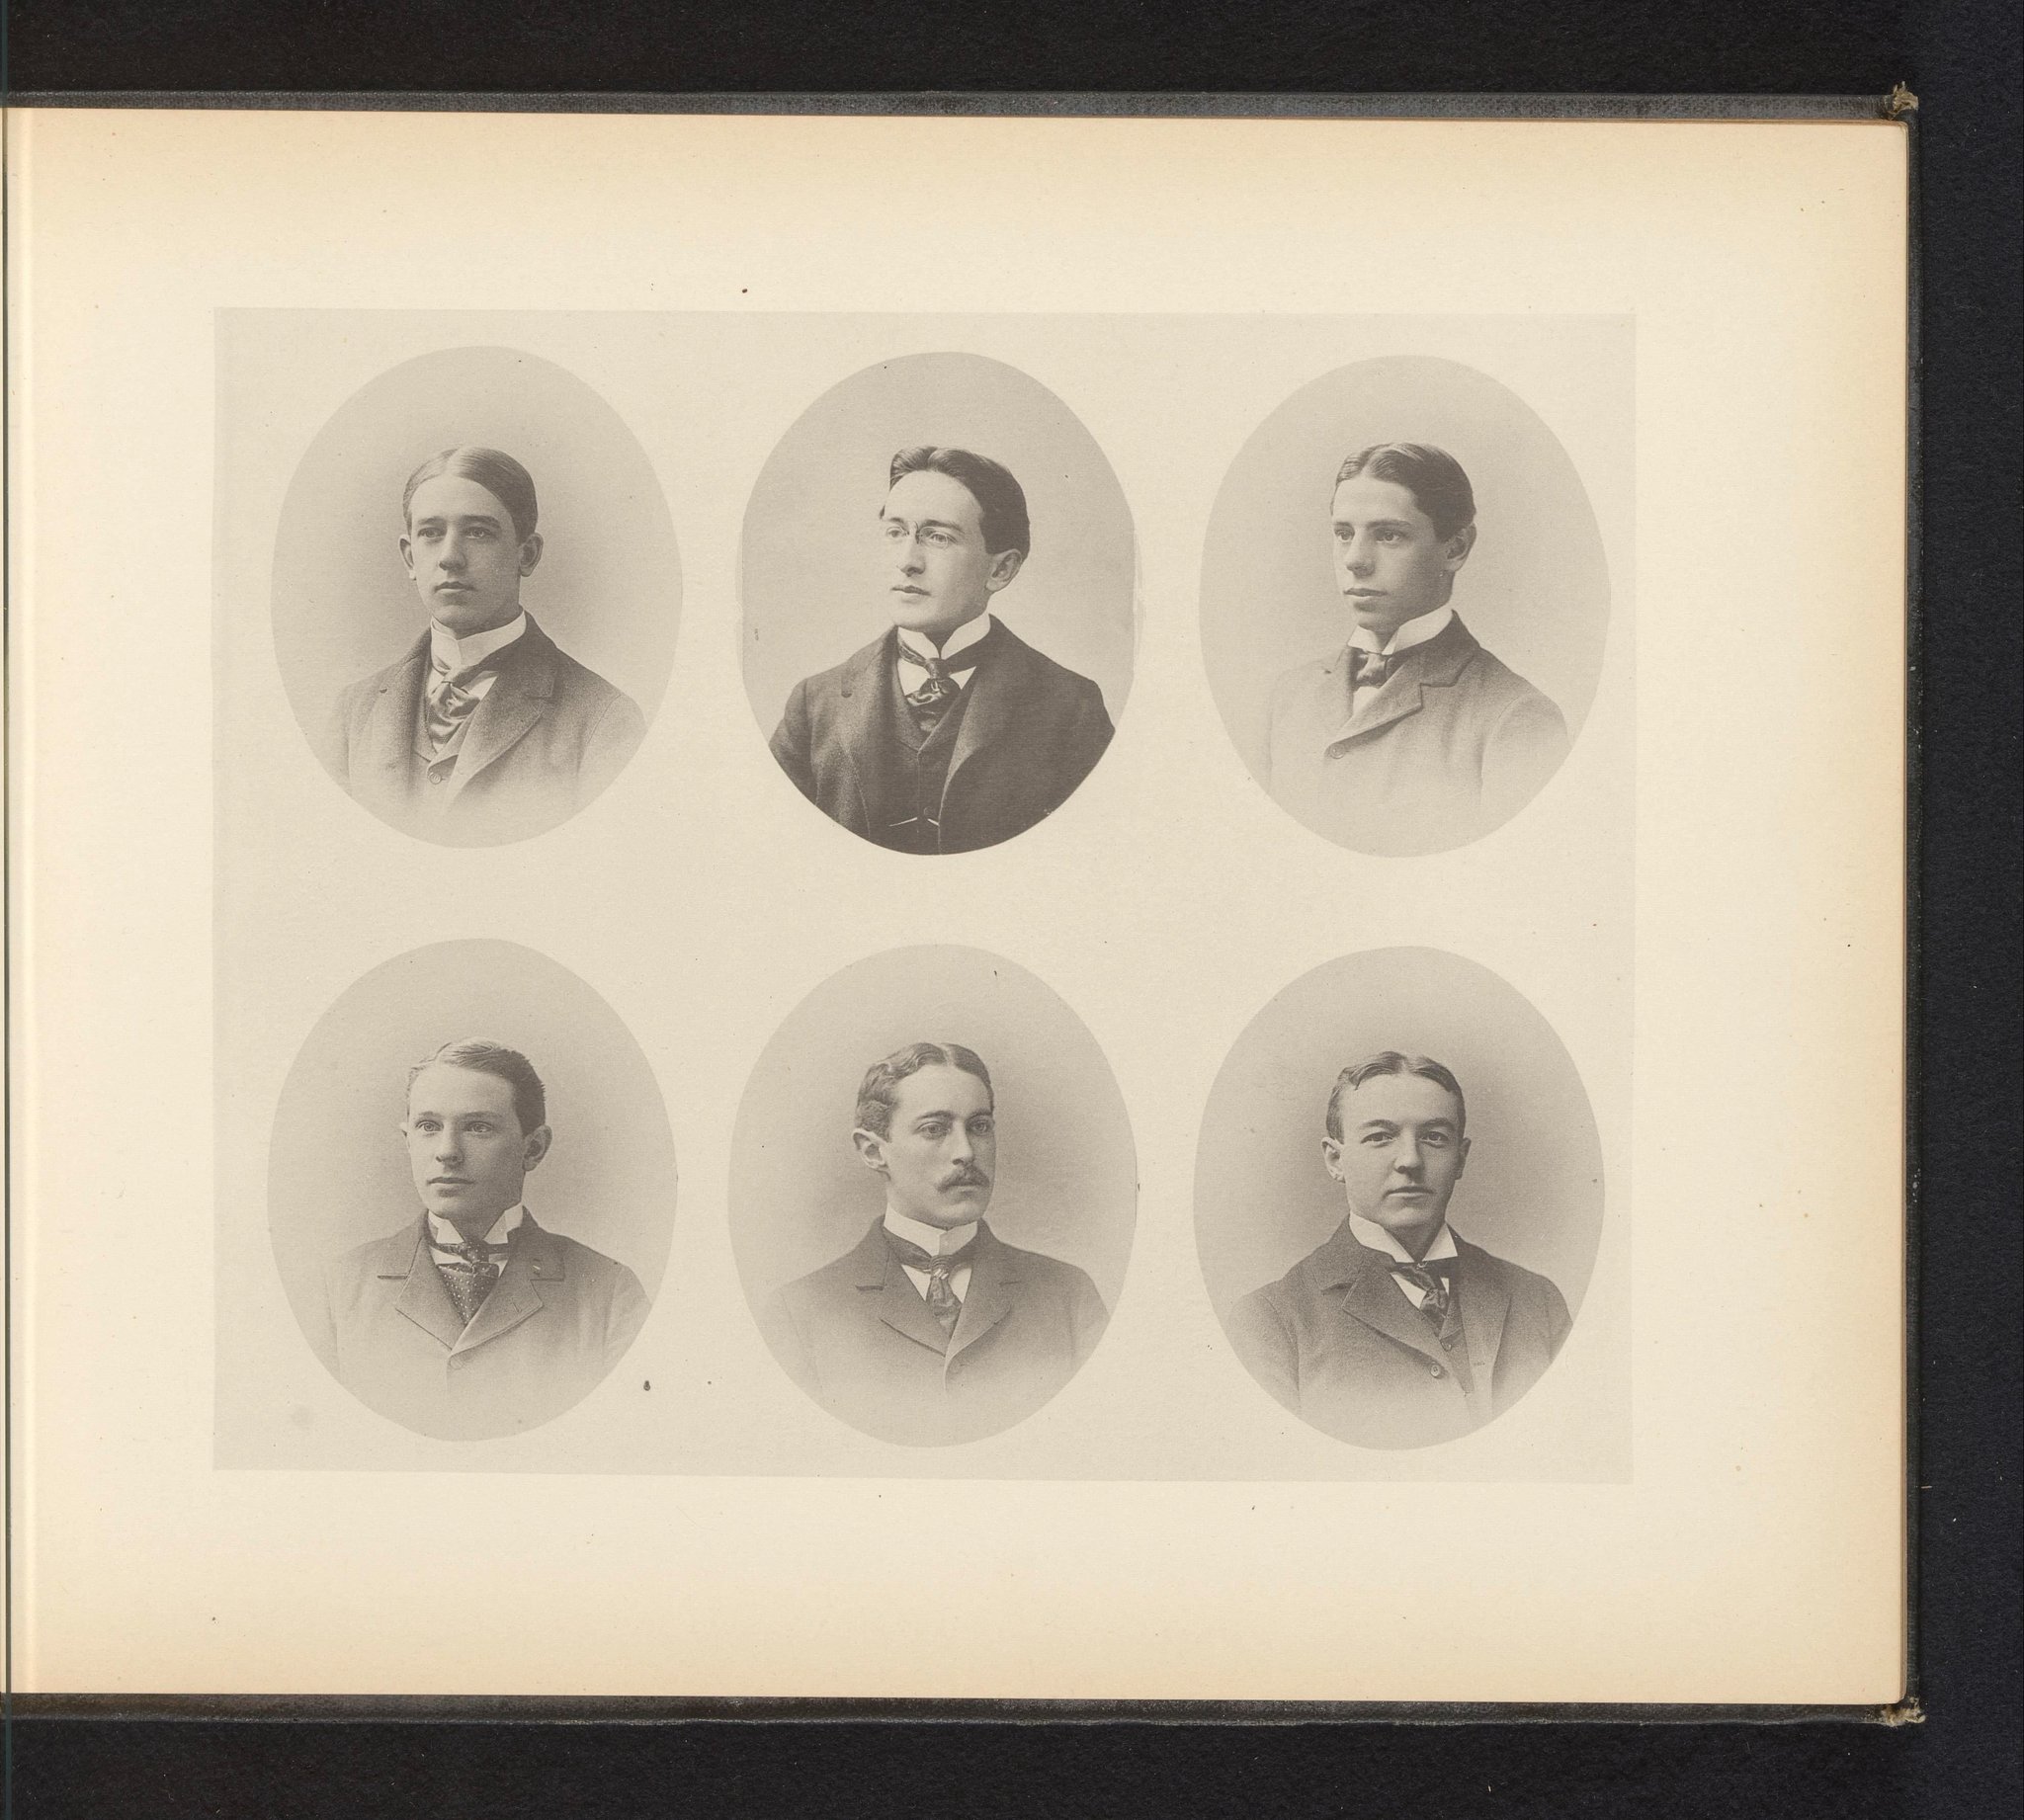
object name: page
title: Zes portretten van afgestudeerde studenten van Yale University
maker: Anonymous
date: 1895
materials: paper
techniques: photograph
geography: new york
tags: student